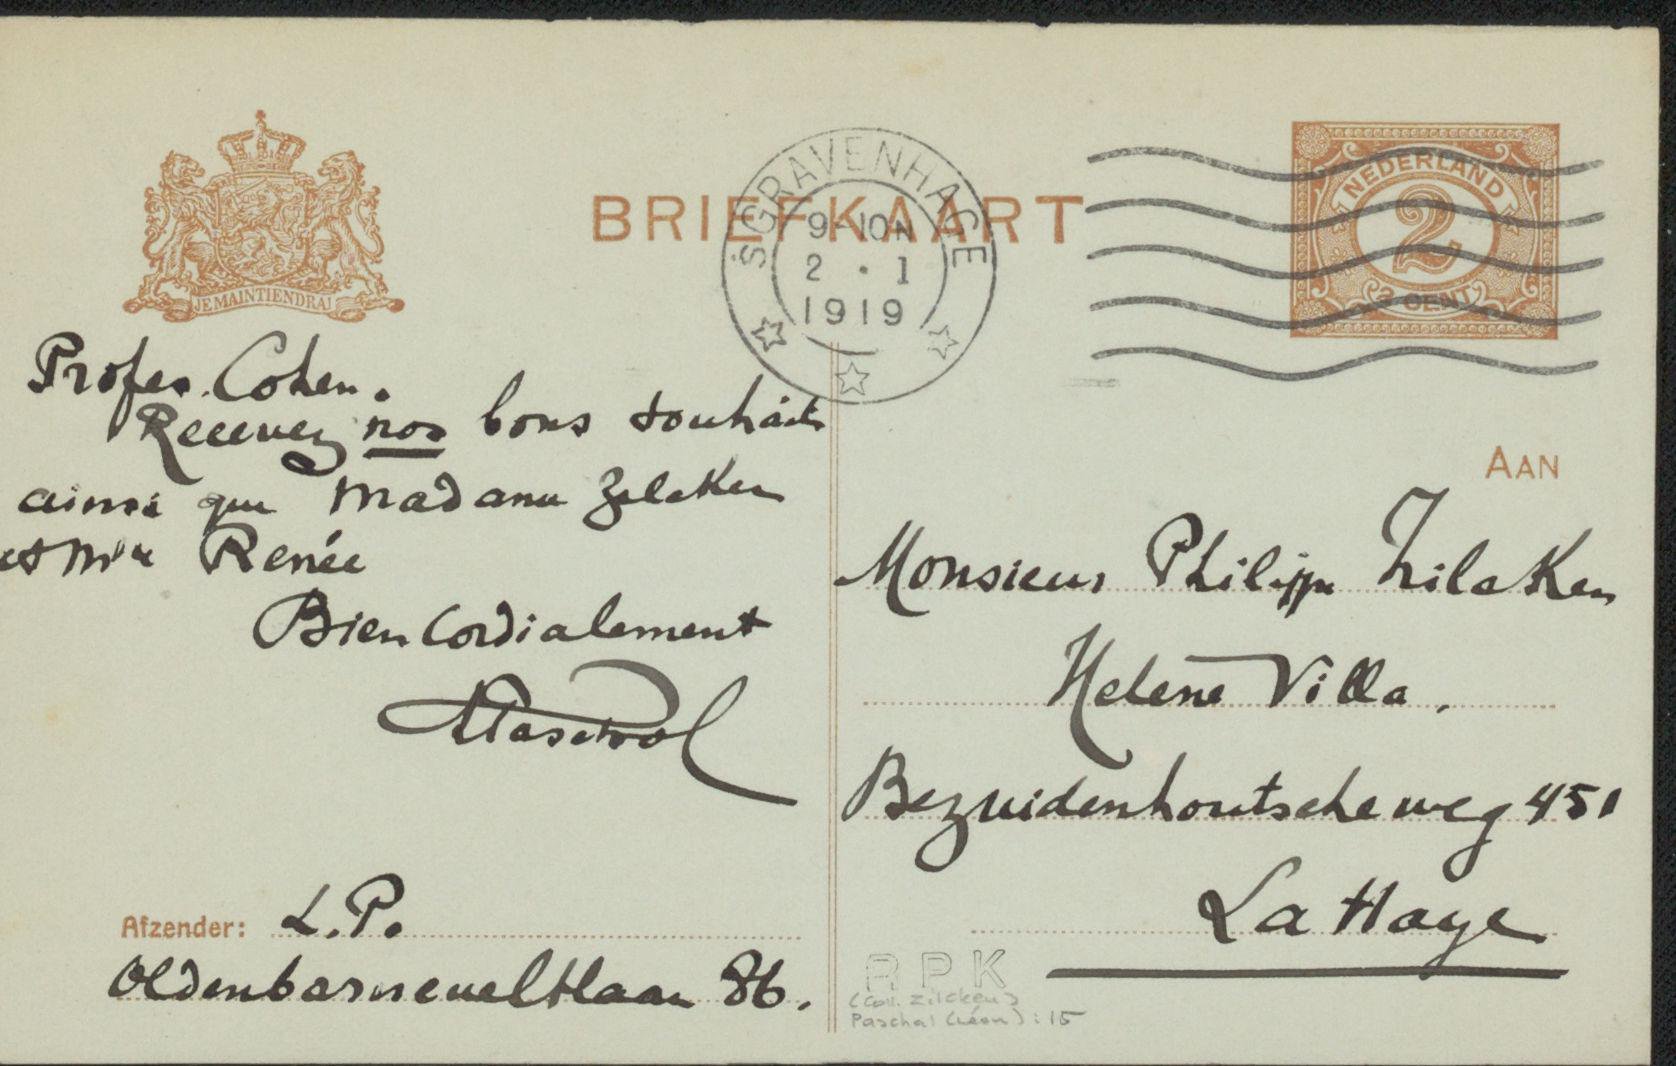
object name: postcard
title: Briefkaart aan Philip Zilcken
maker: léon paschal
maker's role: schrijver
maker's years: 1873-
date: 1919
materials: cardboard, ink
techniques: pen, writing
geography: the hague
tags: the hague, painter, philip zilcken, printed matter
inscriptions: collector's mark: ‘RPK’